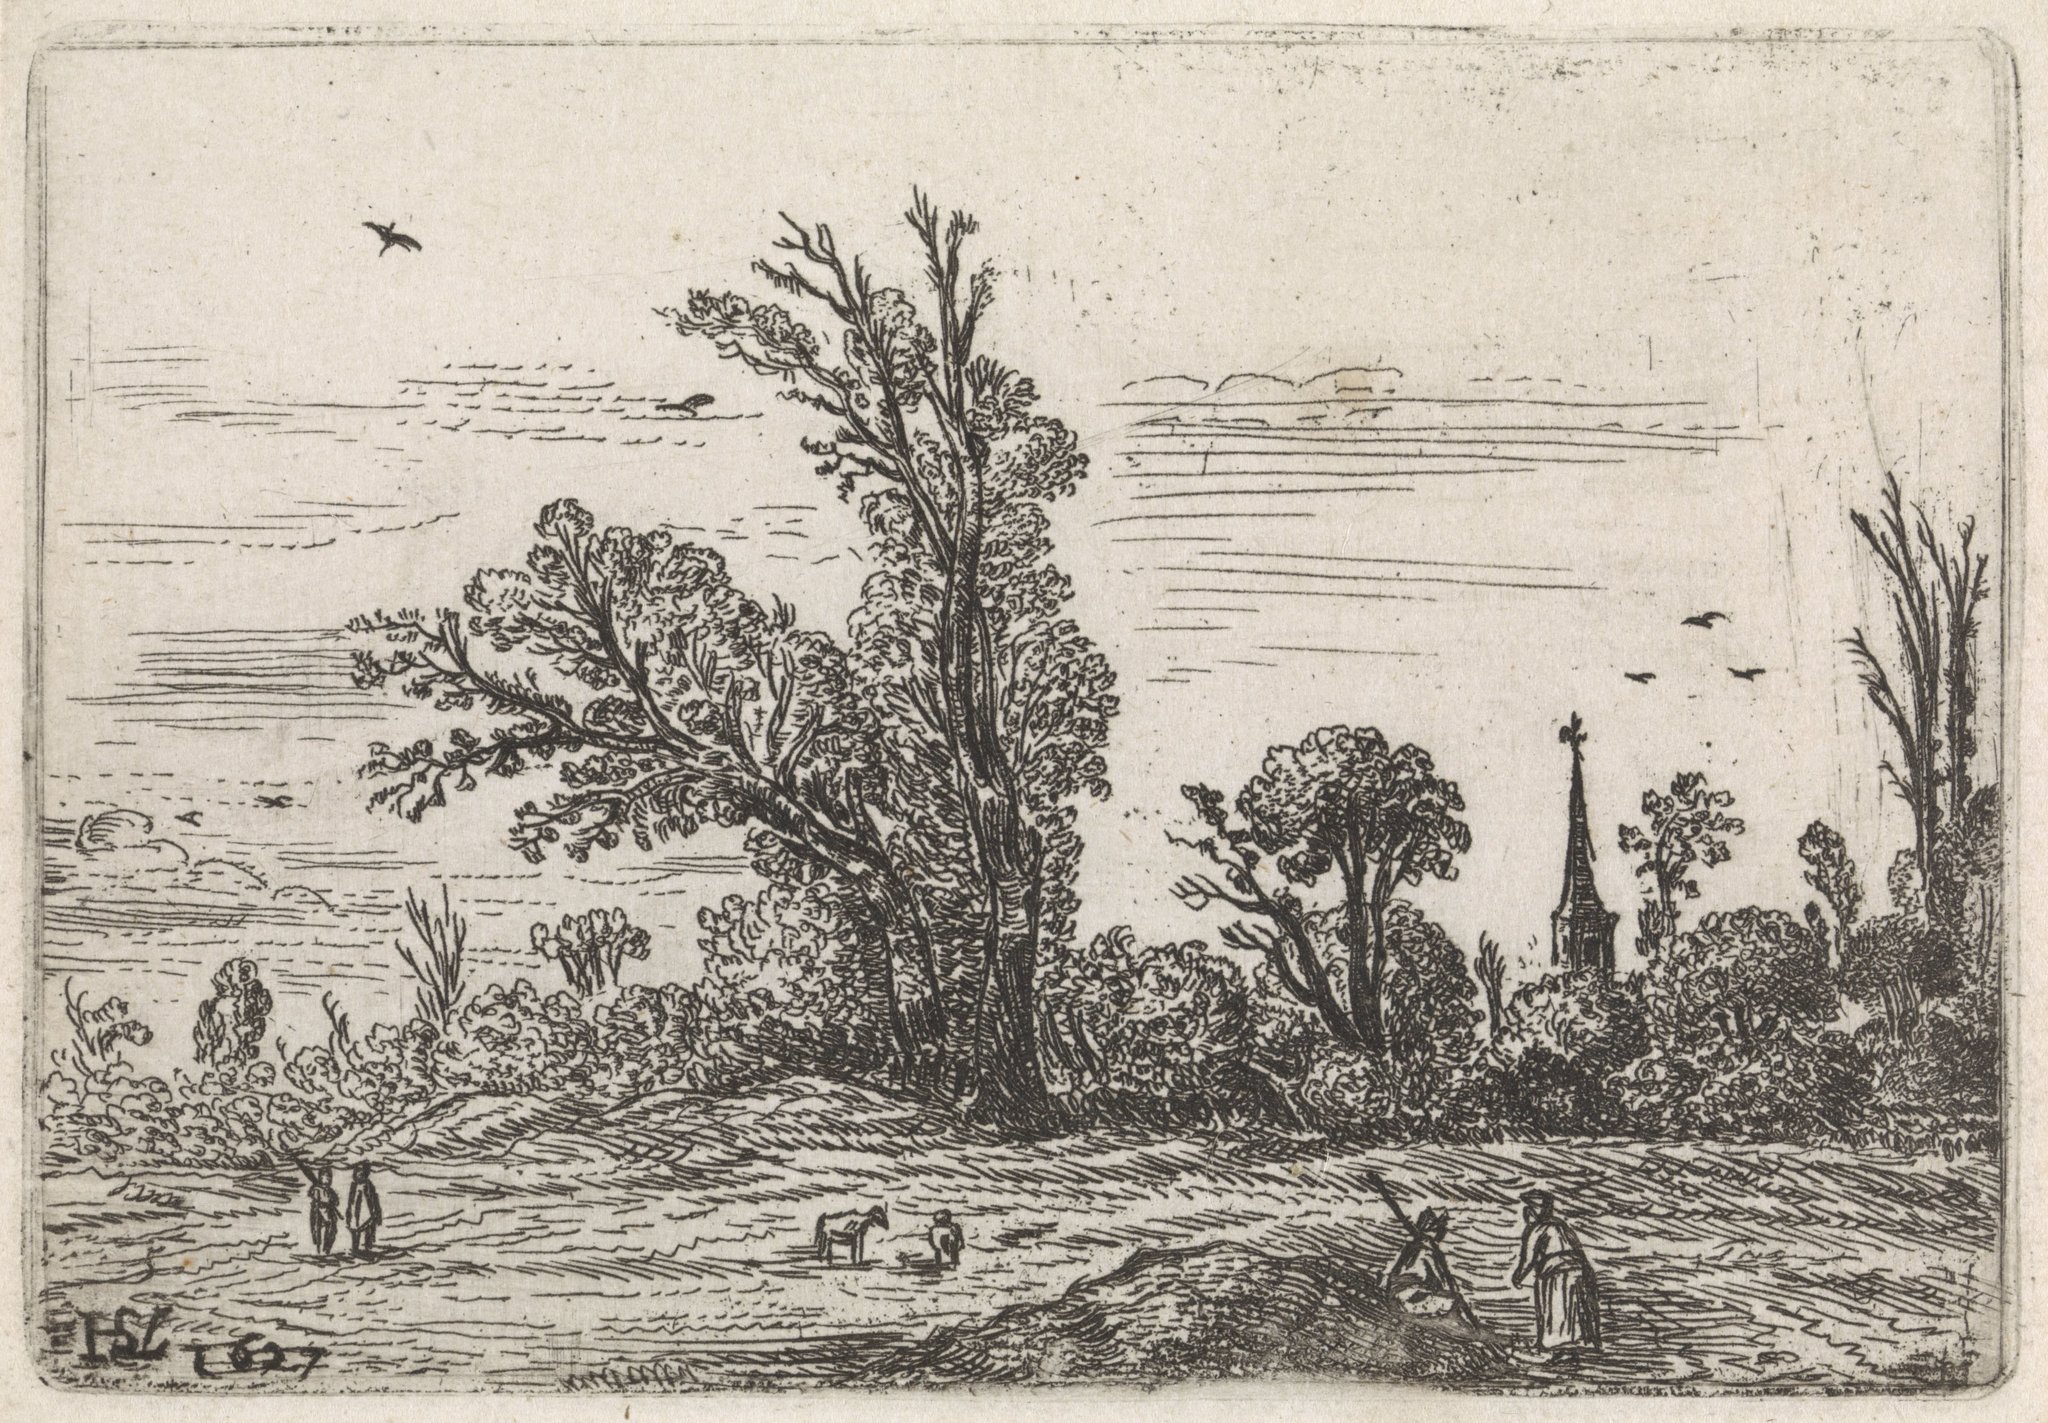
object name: print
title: Veld met figuren, bomen en kerktoren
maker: herman saftleven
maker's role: draughtsman, painter, print maker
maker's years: 1609-1685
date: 1627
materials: paper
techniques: etching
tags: landscapes, farm or solitary house in landscape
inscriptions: collector's mark: Lugt 240